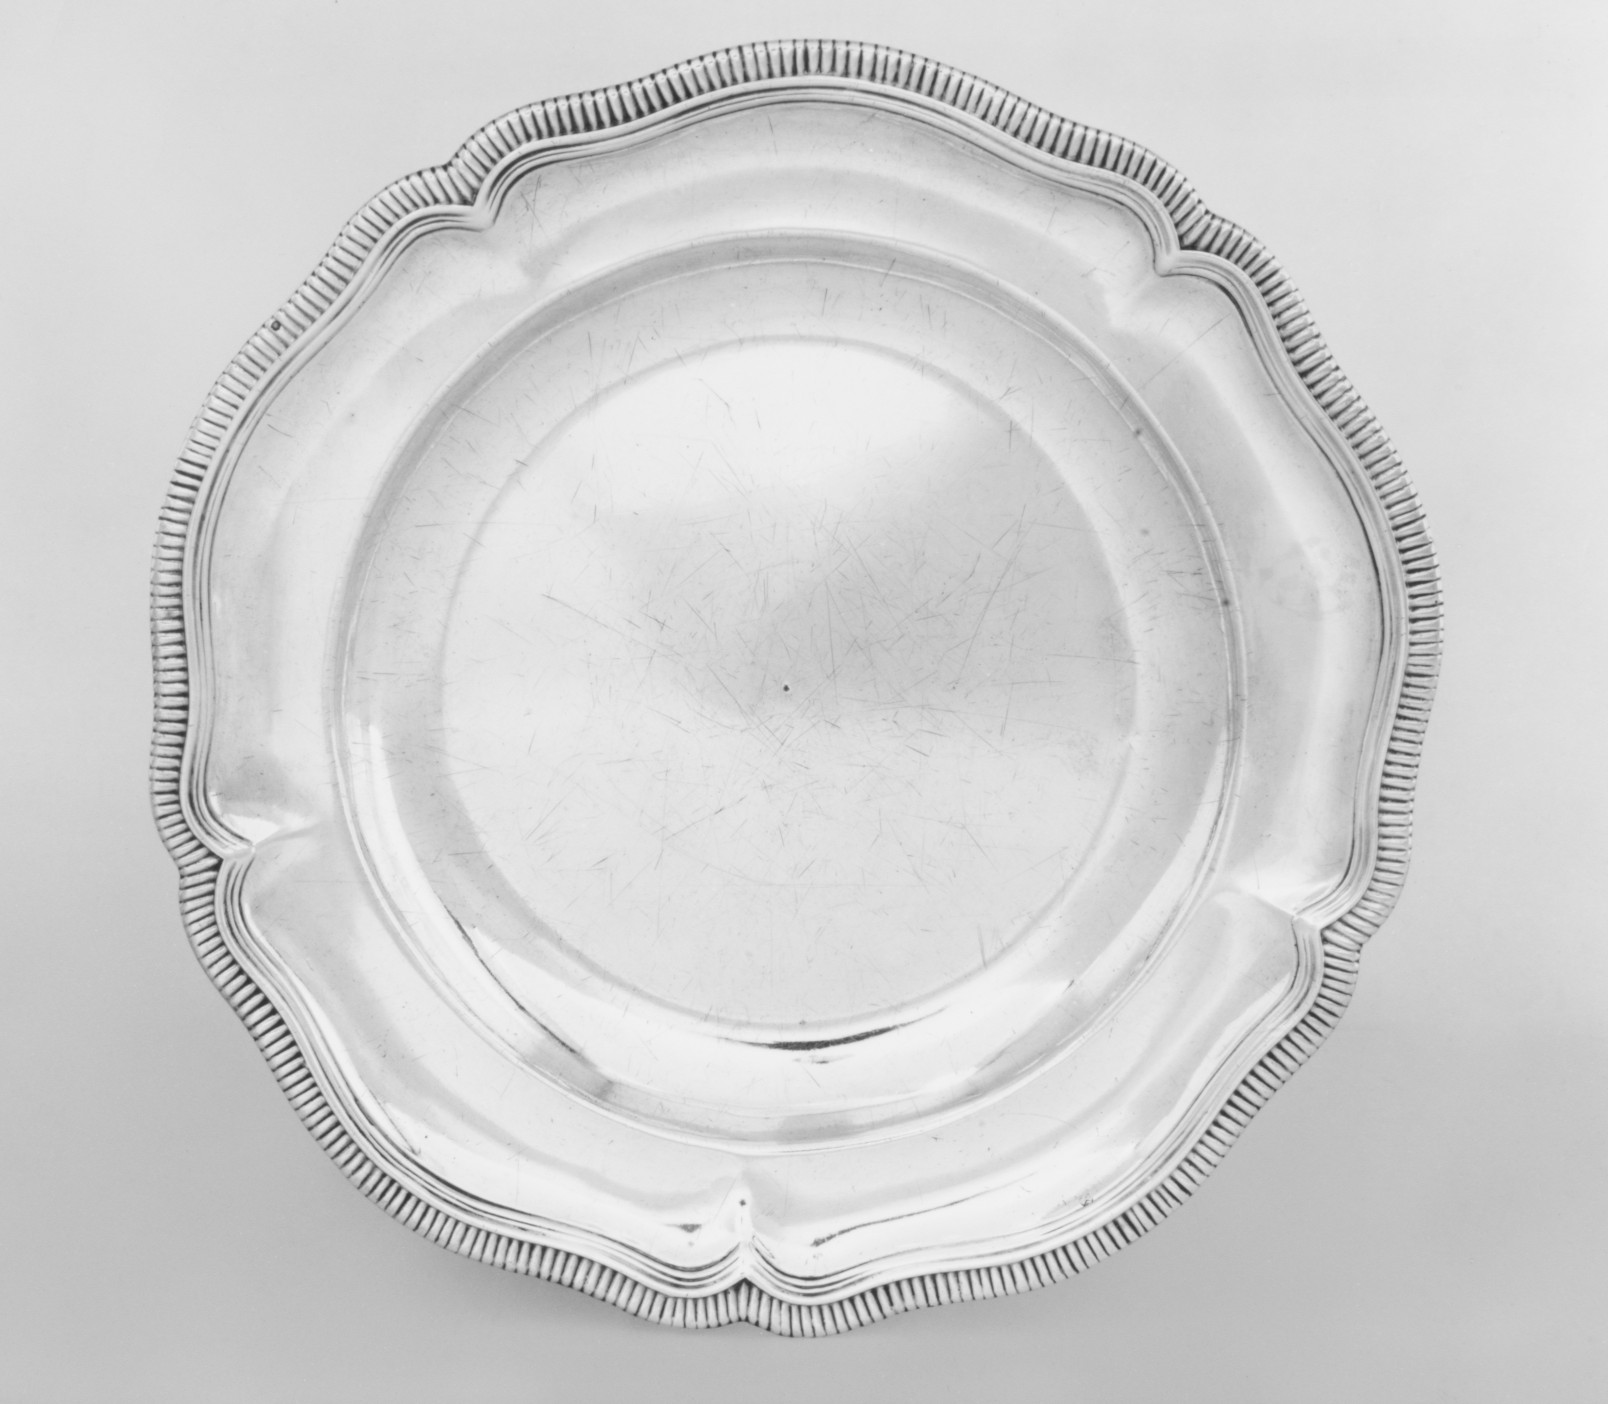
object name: plate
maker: alexis micalef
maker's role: maker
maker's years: 1726-1818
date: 1758-1759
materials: silver